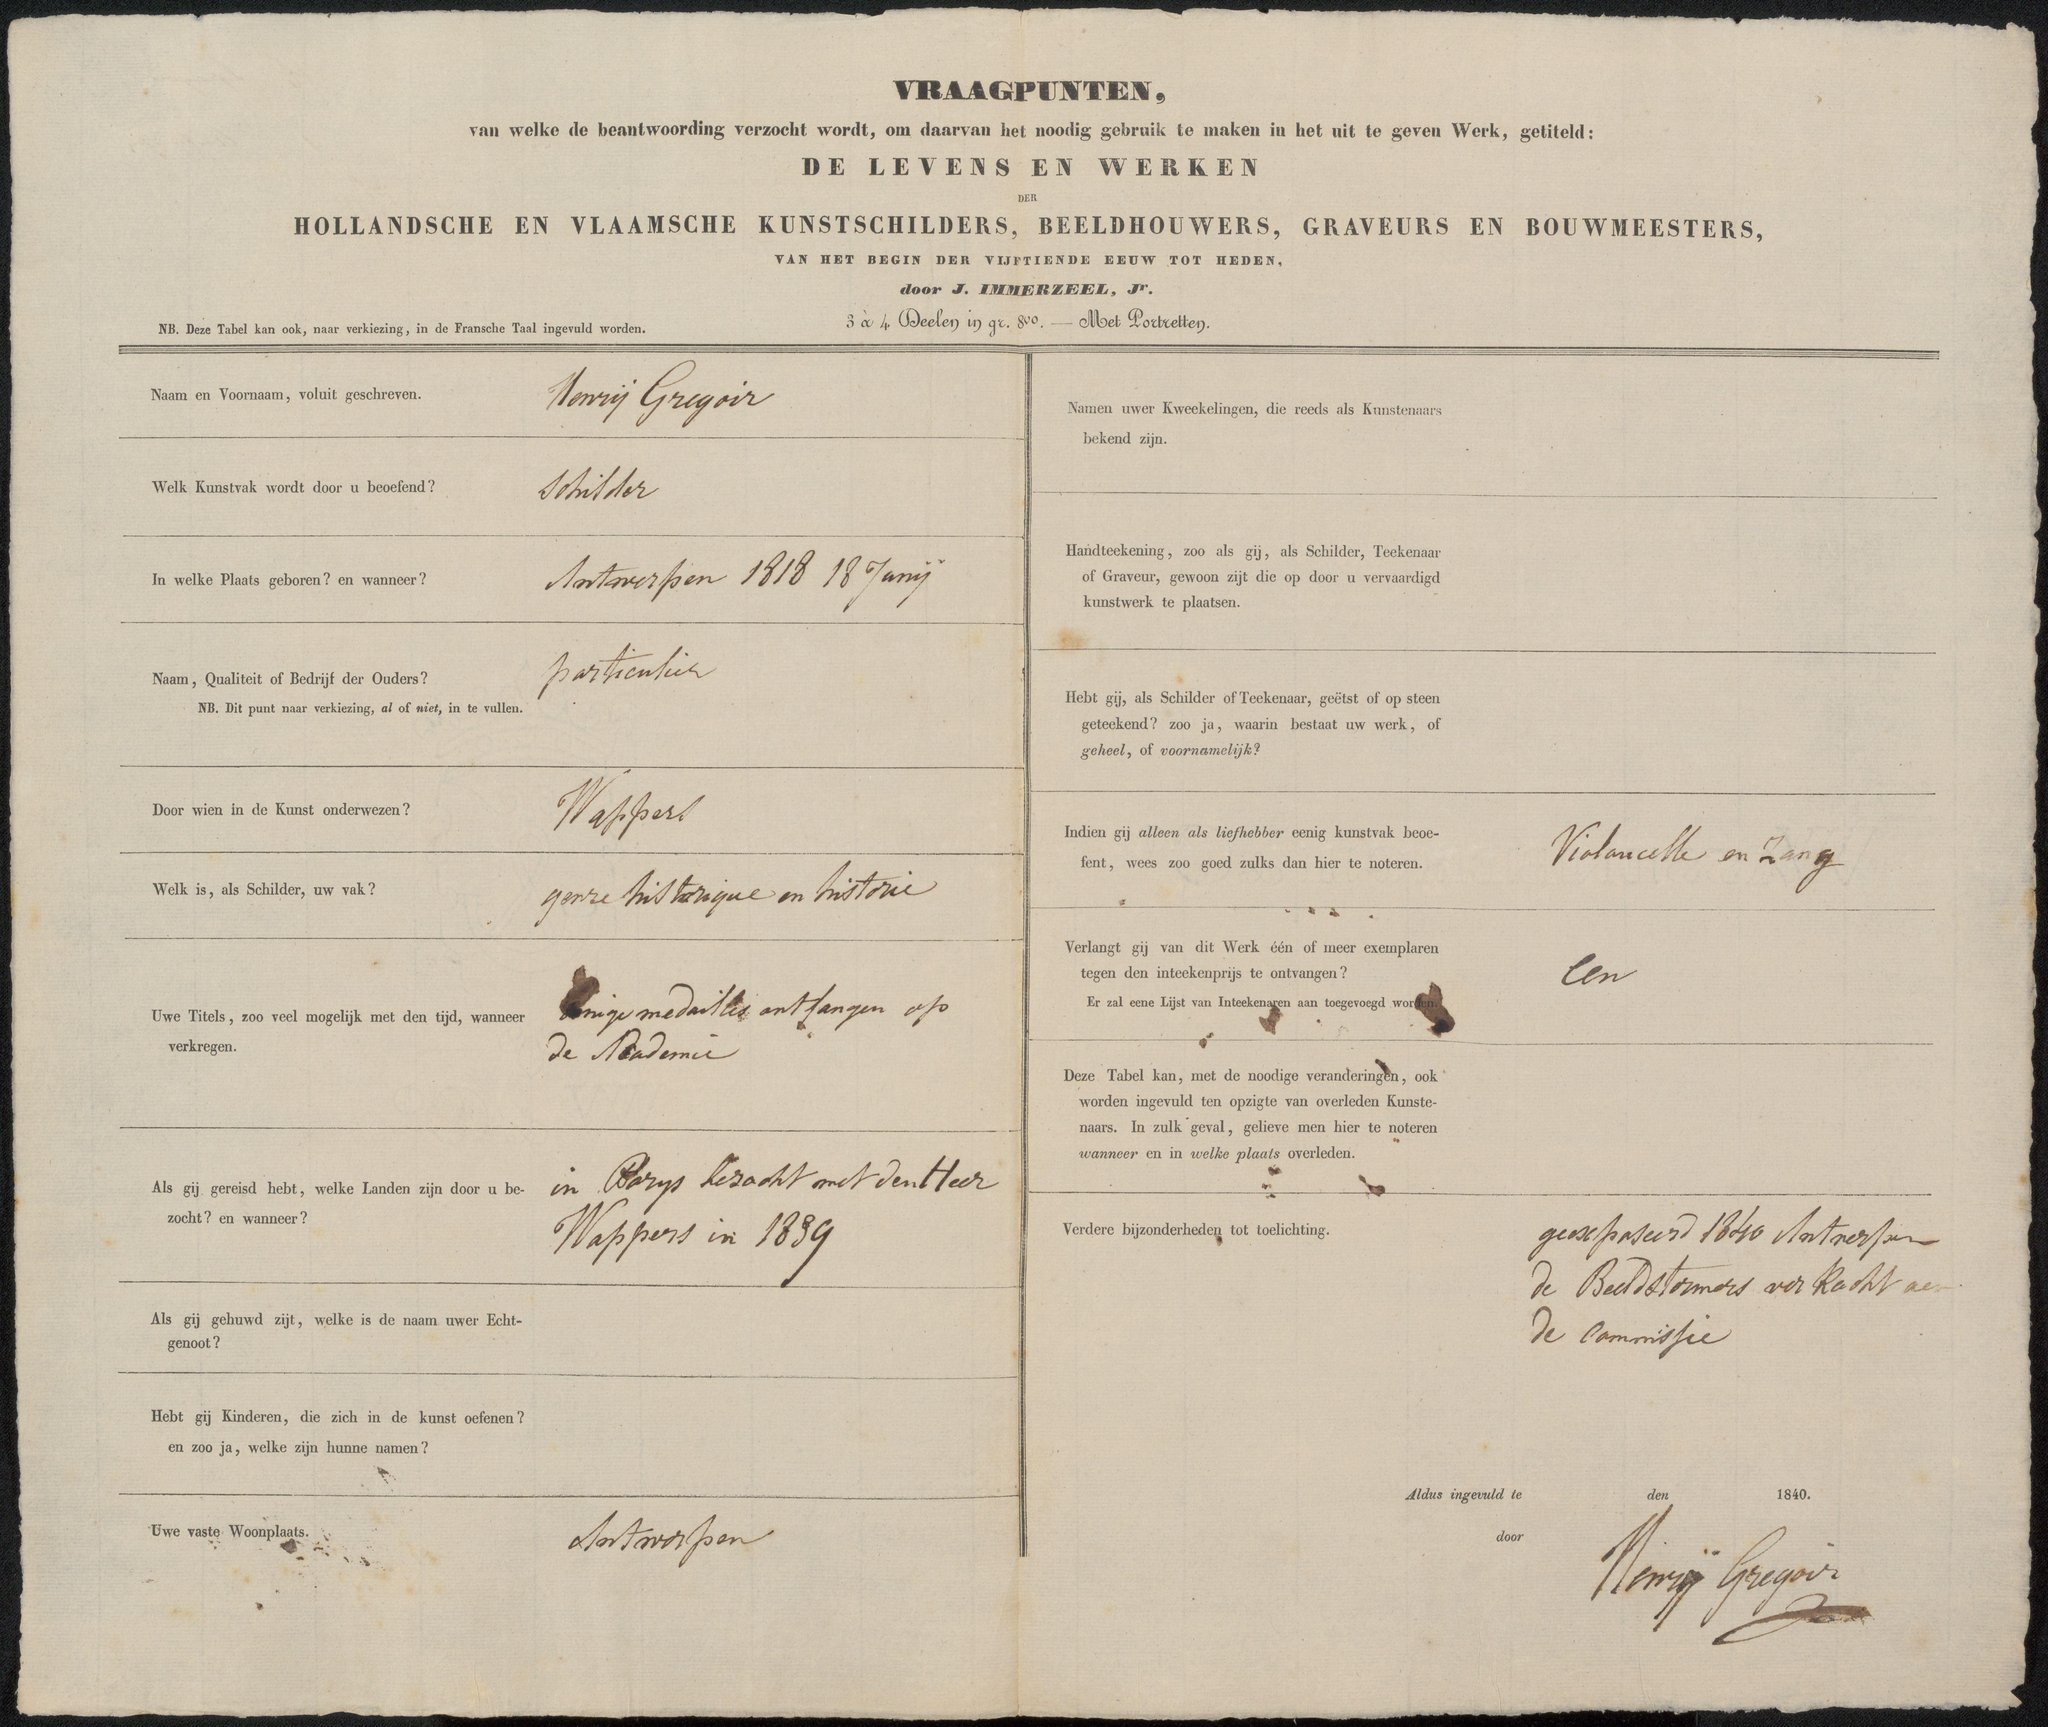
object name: manuscript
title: Enquêteformulier ingevuld door Henri Grégoir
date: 1840-1841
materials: ink, paper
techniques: pen, printing, writing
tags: painter, henri grégoir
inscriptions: inscription: ‘Vraagpunten,/ van welke de beantwoording verzocht wordt, om daarvan het noodig gebruik te maken in het uit te geven Werk, getiteld: De levens en werken/ der Hollandsche en Vlaamsche kunstschilders, beeldhouwers,/ graveurs en bouwmeesters, van het begin der vijftiende eeuw tot heden/ door J. Immerzeel, Jr.’, watermark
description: Opgenomen in: Immerzeel, J. Jr., De levens en werken der Hollandsche en Vlaamsche kunstschilders, beeldhouwers, graveurs en bouwmeesters, van het begin der vijftiende eeuw tot heden, Amsterdam: J.C. van Kesteren, 1842-1843.